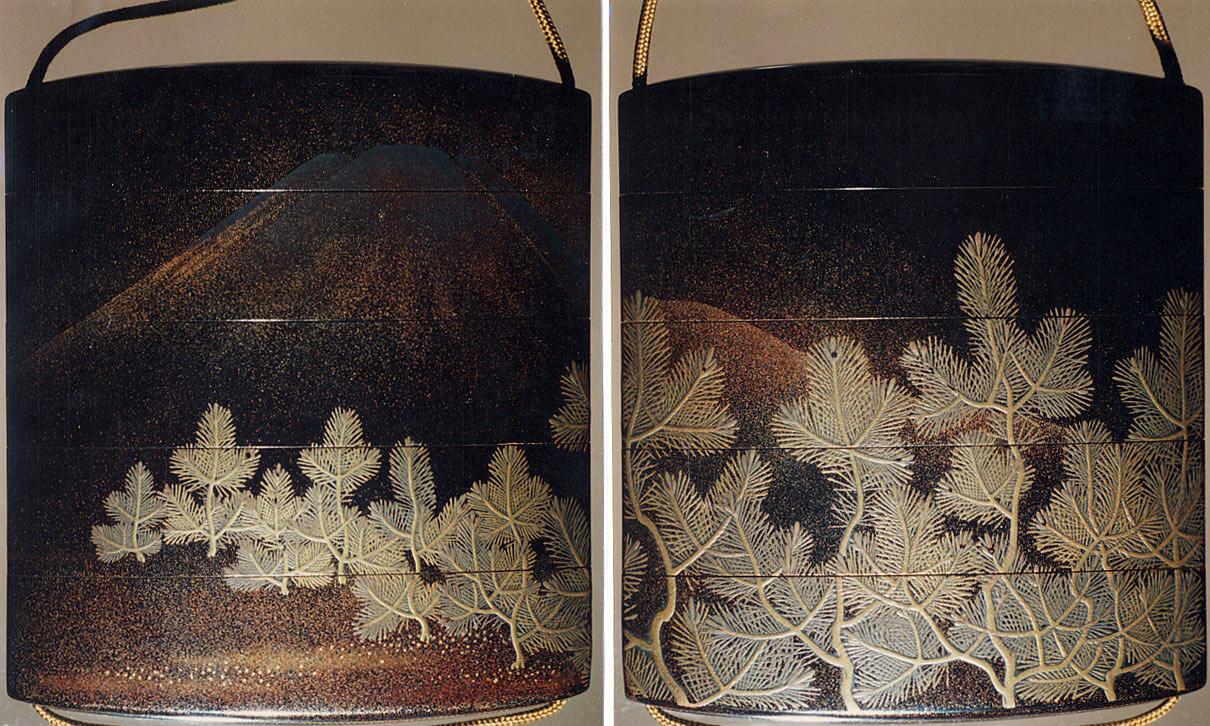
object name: inrō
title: Case (Inrō) with Design of Pine Branches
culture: japanese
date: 1701-1900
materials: gold, lacquer, silver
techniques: fundame, hiramakie, roiro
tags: trees